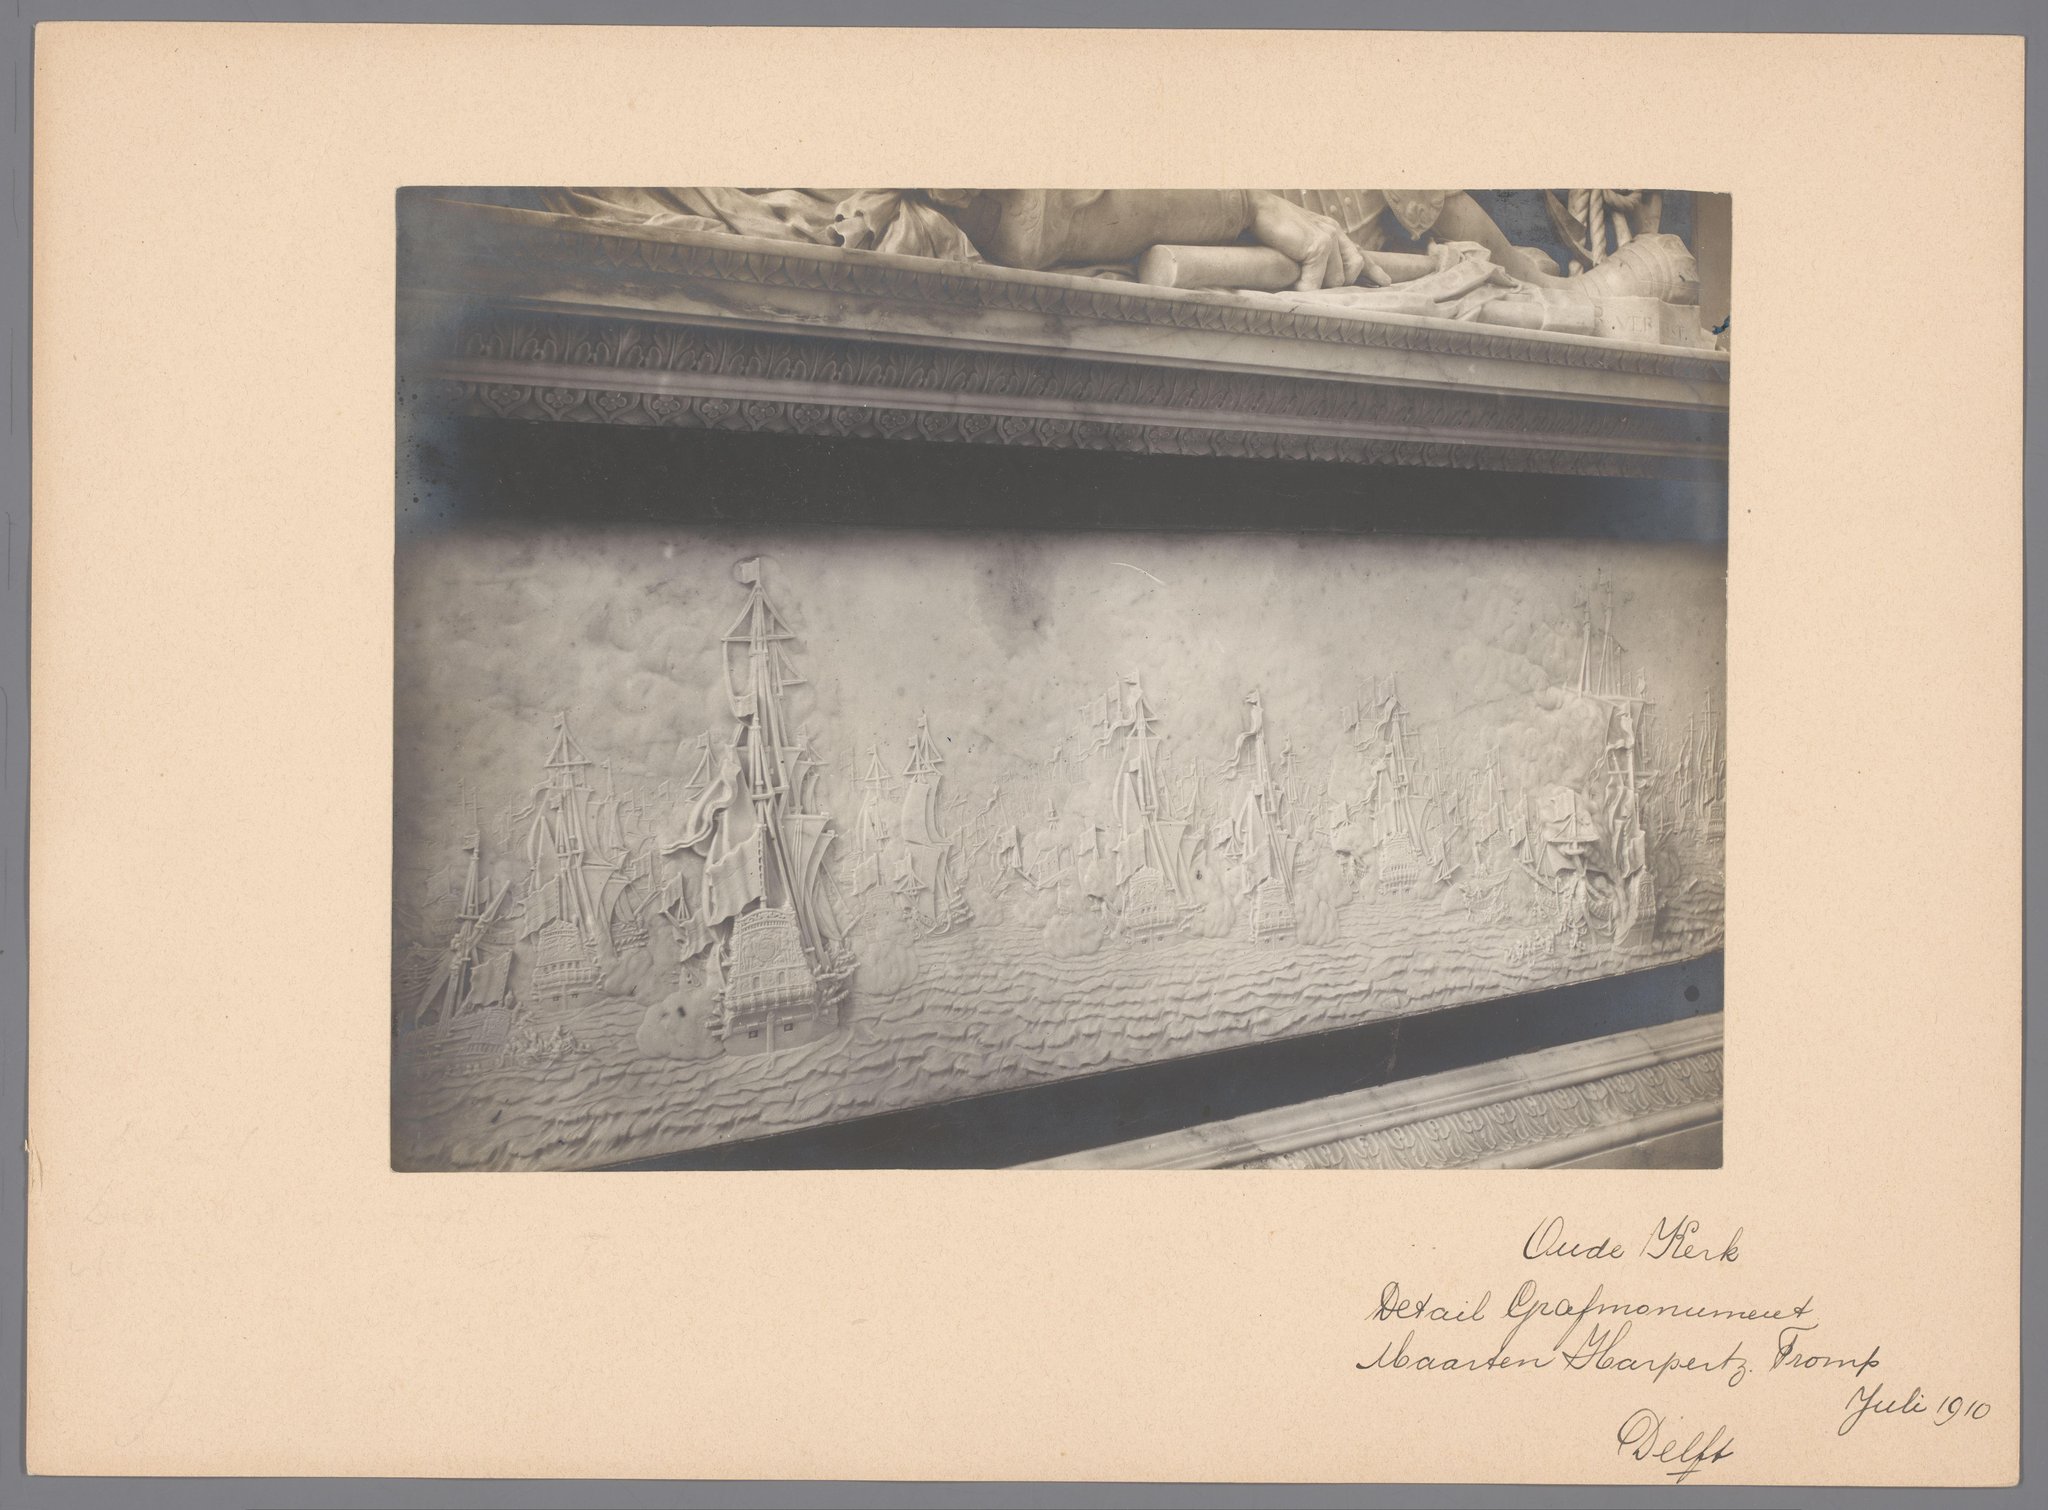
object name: photograph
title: Grafmonument van Maarten Tromp in de Oude Kerk te Delft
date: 1910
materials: cardboard, photographic support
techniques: gelatin silver print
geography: oude kerk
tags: brielle, maarten harpertszoon tromp, interior of church, grave-building, monumental tomb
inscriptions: annotation: ‘Oude Kerk/ Detail grafmonument Maarten Harpertz. Tromp/ Juli 1910/ Delft’